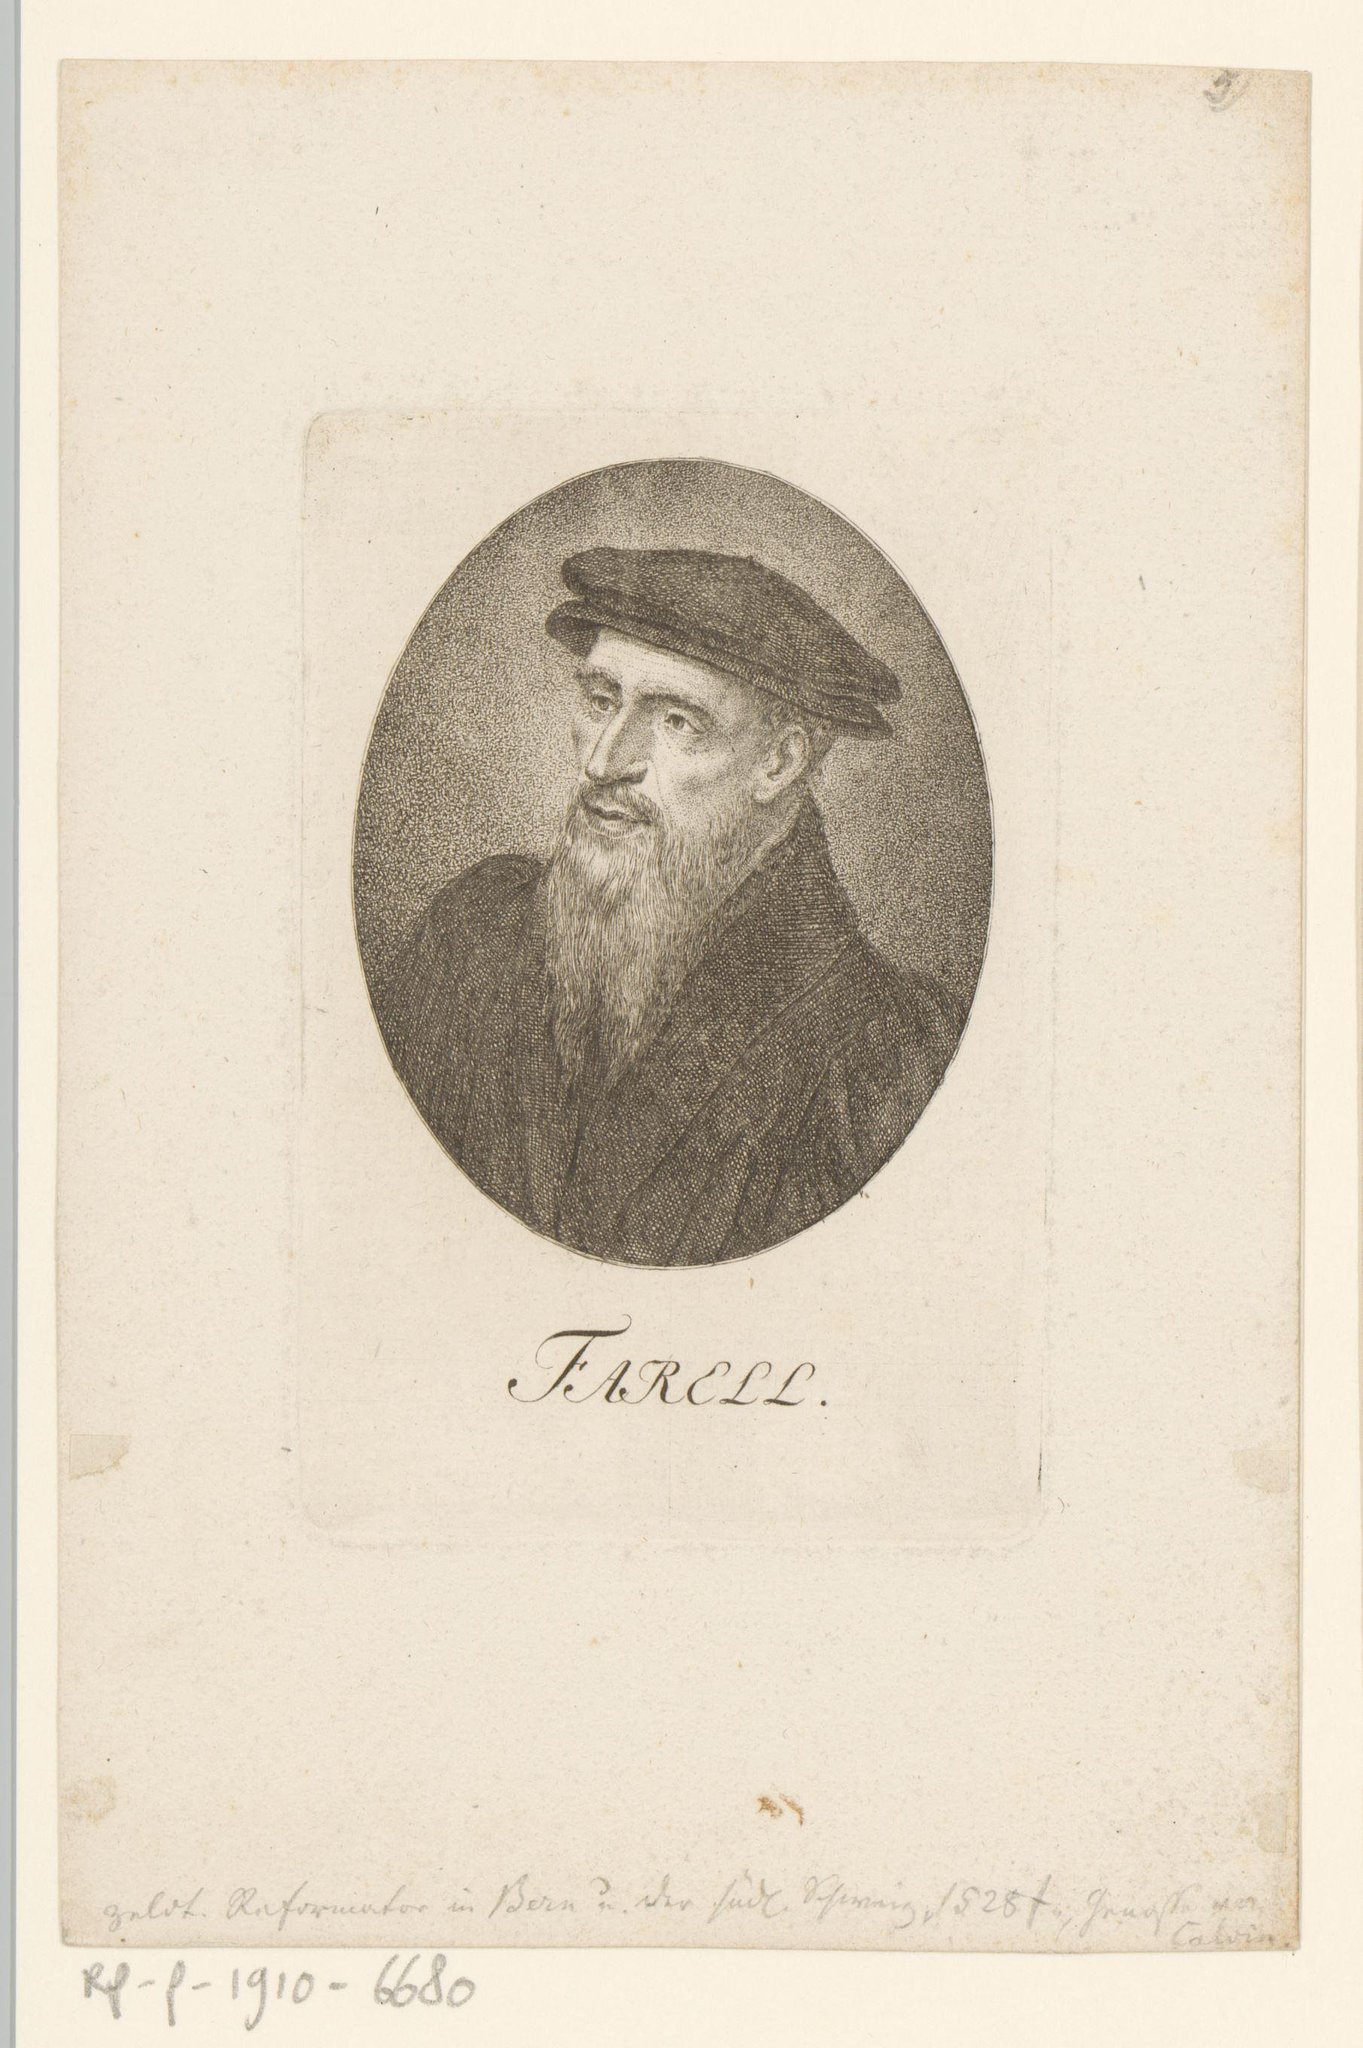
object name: print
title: Portret van Guilliaume Farel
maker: heinrich pfenninger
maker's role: print maker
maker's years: 1749-1815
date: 1759-1815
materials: paper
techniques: etching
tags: historical persons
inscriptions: collector's mark: Lugt 2228